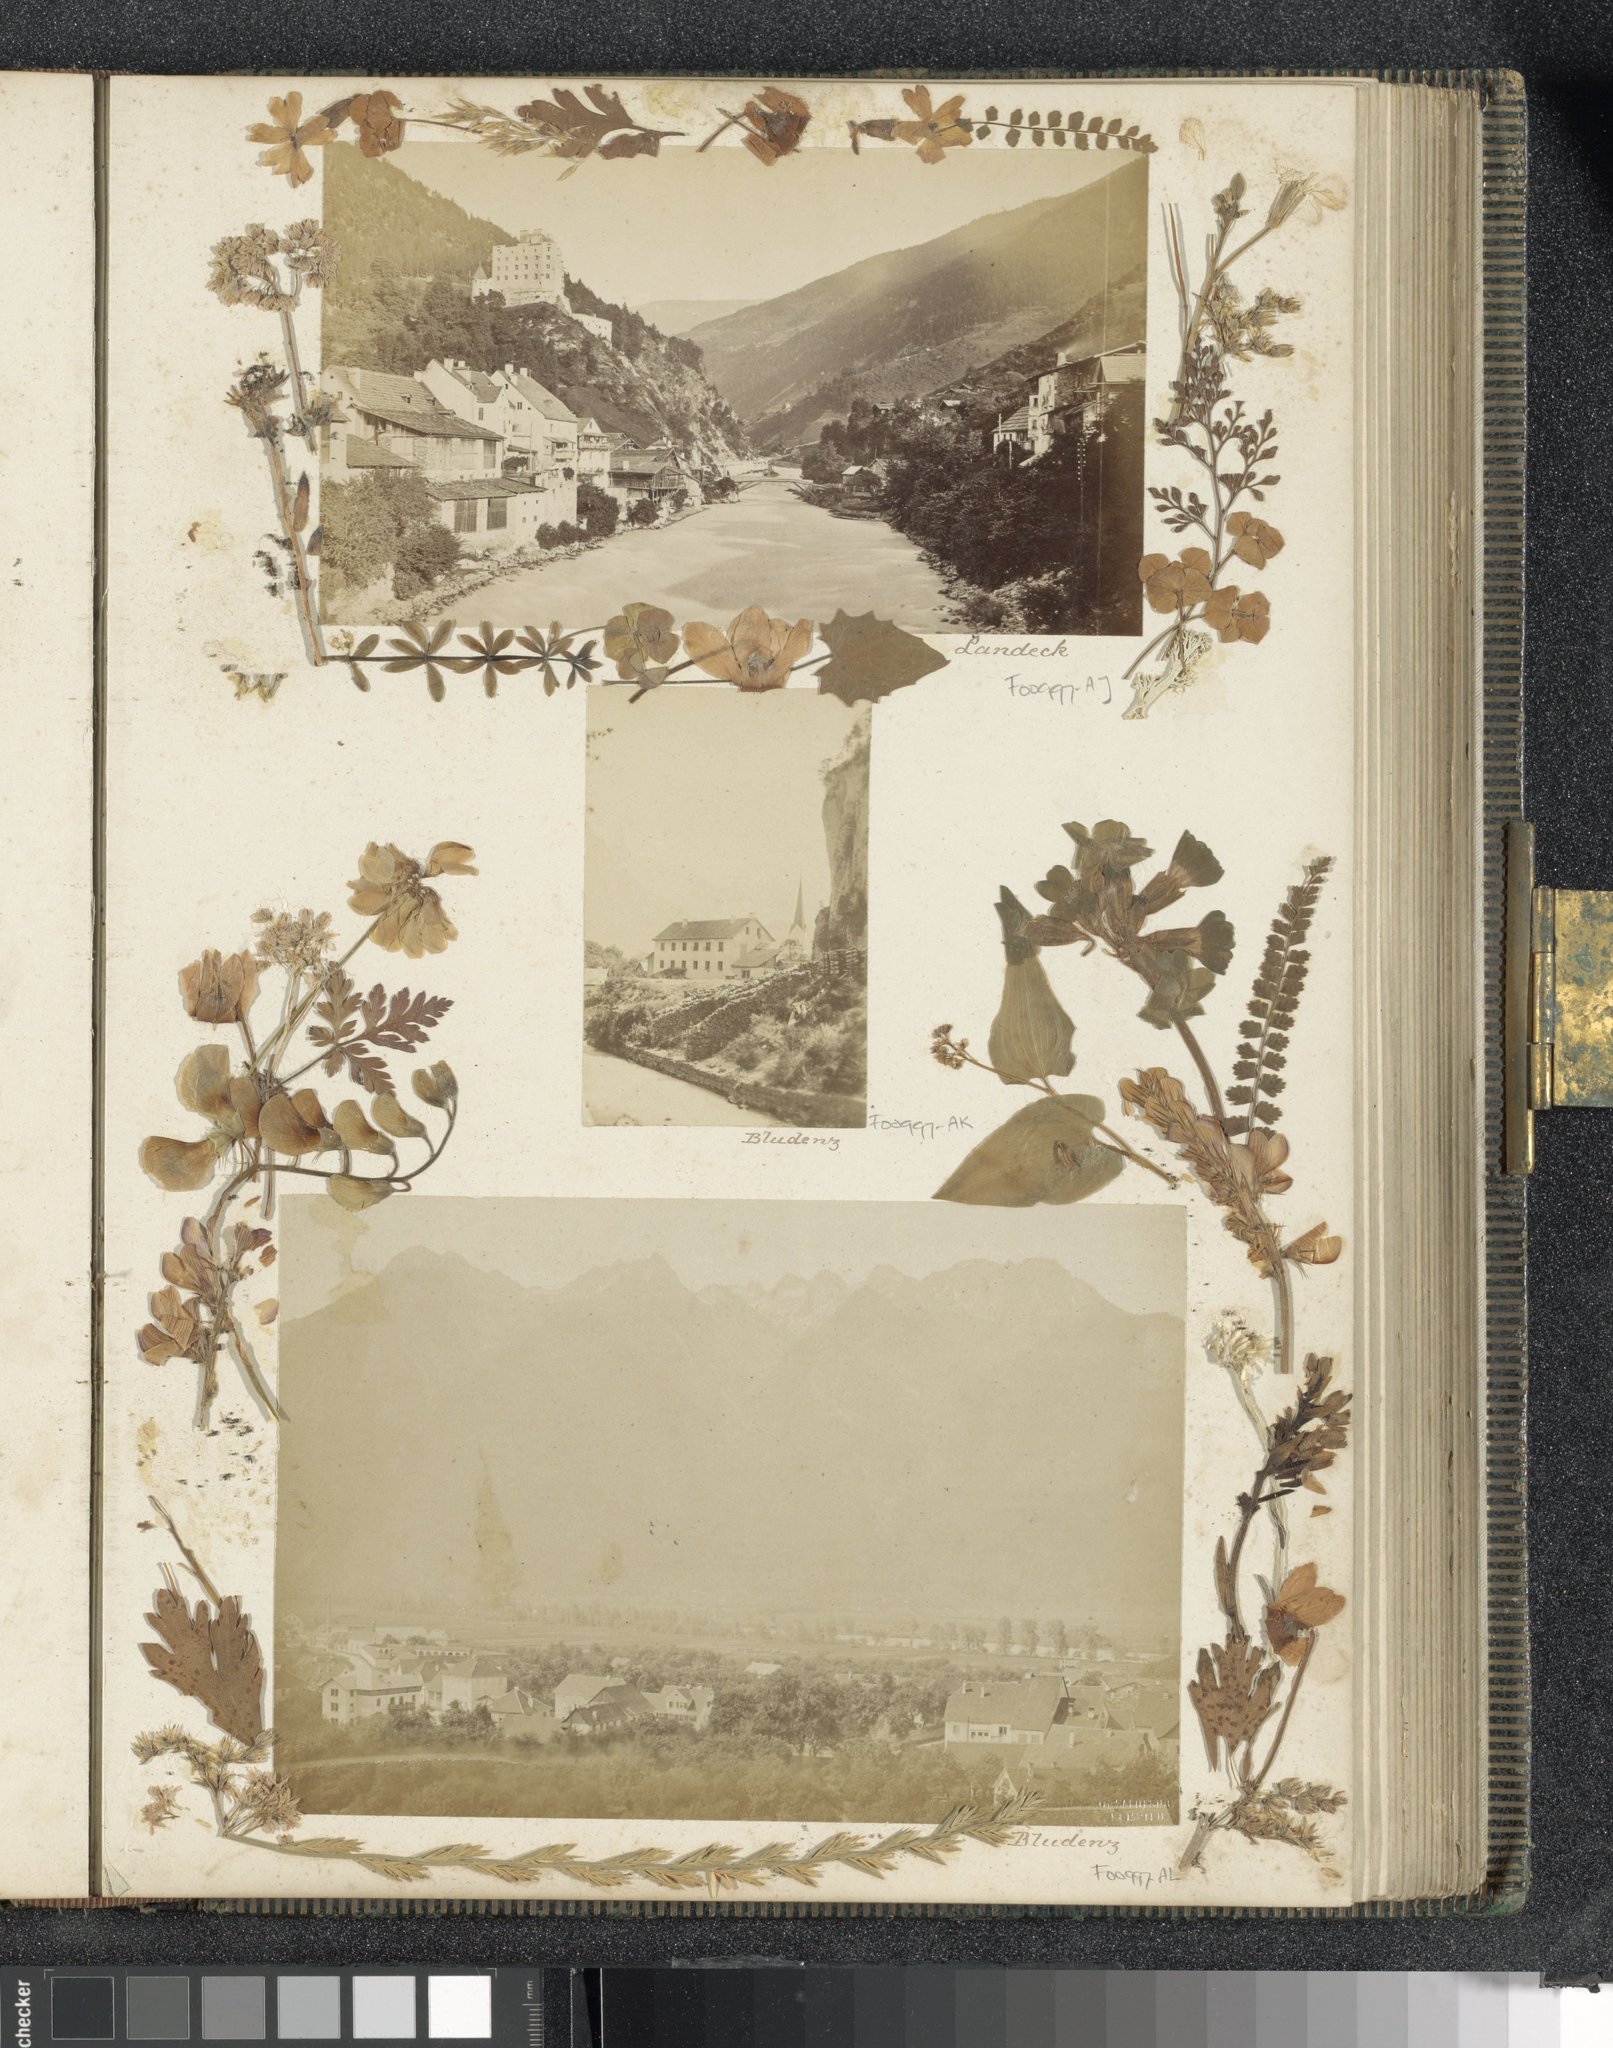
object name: photograph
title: Landeck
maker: Anonymous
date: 1860-1890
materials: paper, photographic support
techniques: albumen print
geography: landeck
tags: prospect of village, silhouette of village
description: Onderdeel van Reisalbum met foto's van Zwitserland, Oostenrijk, Italië en Duitsland.